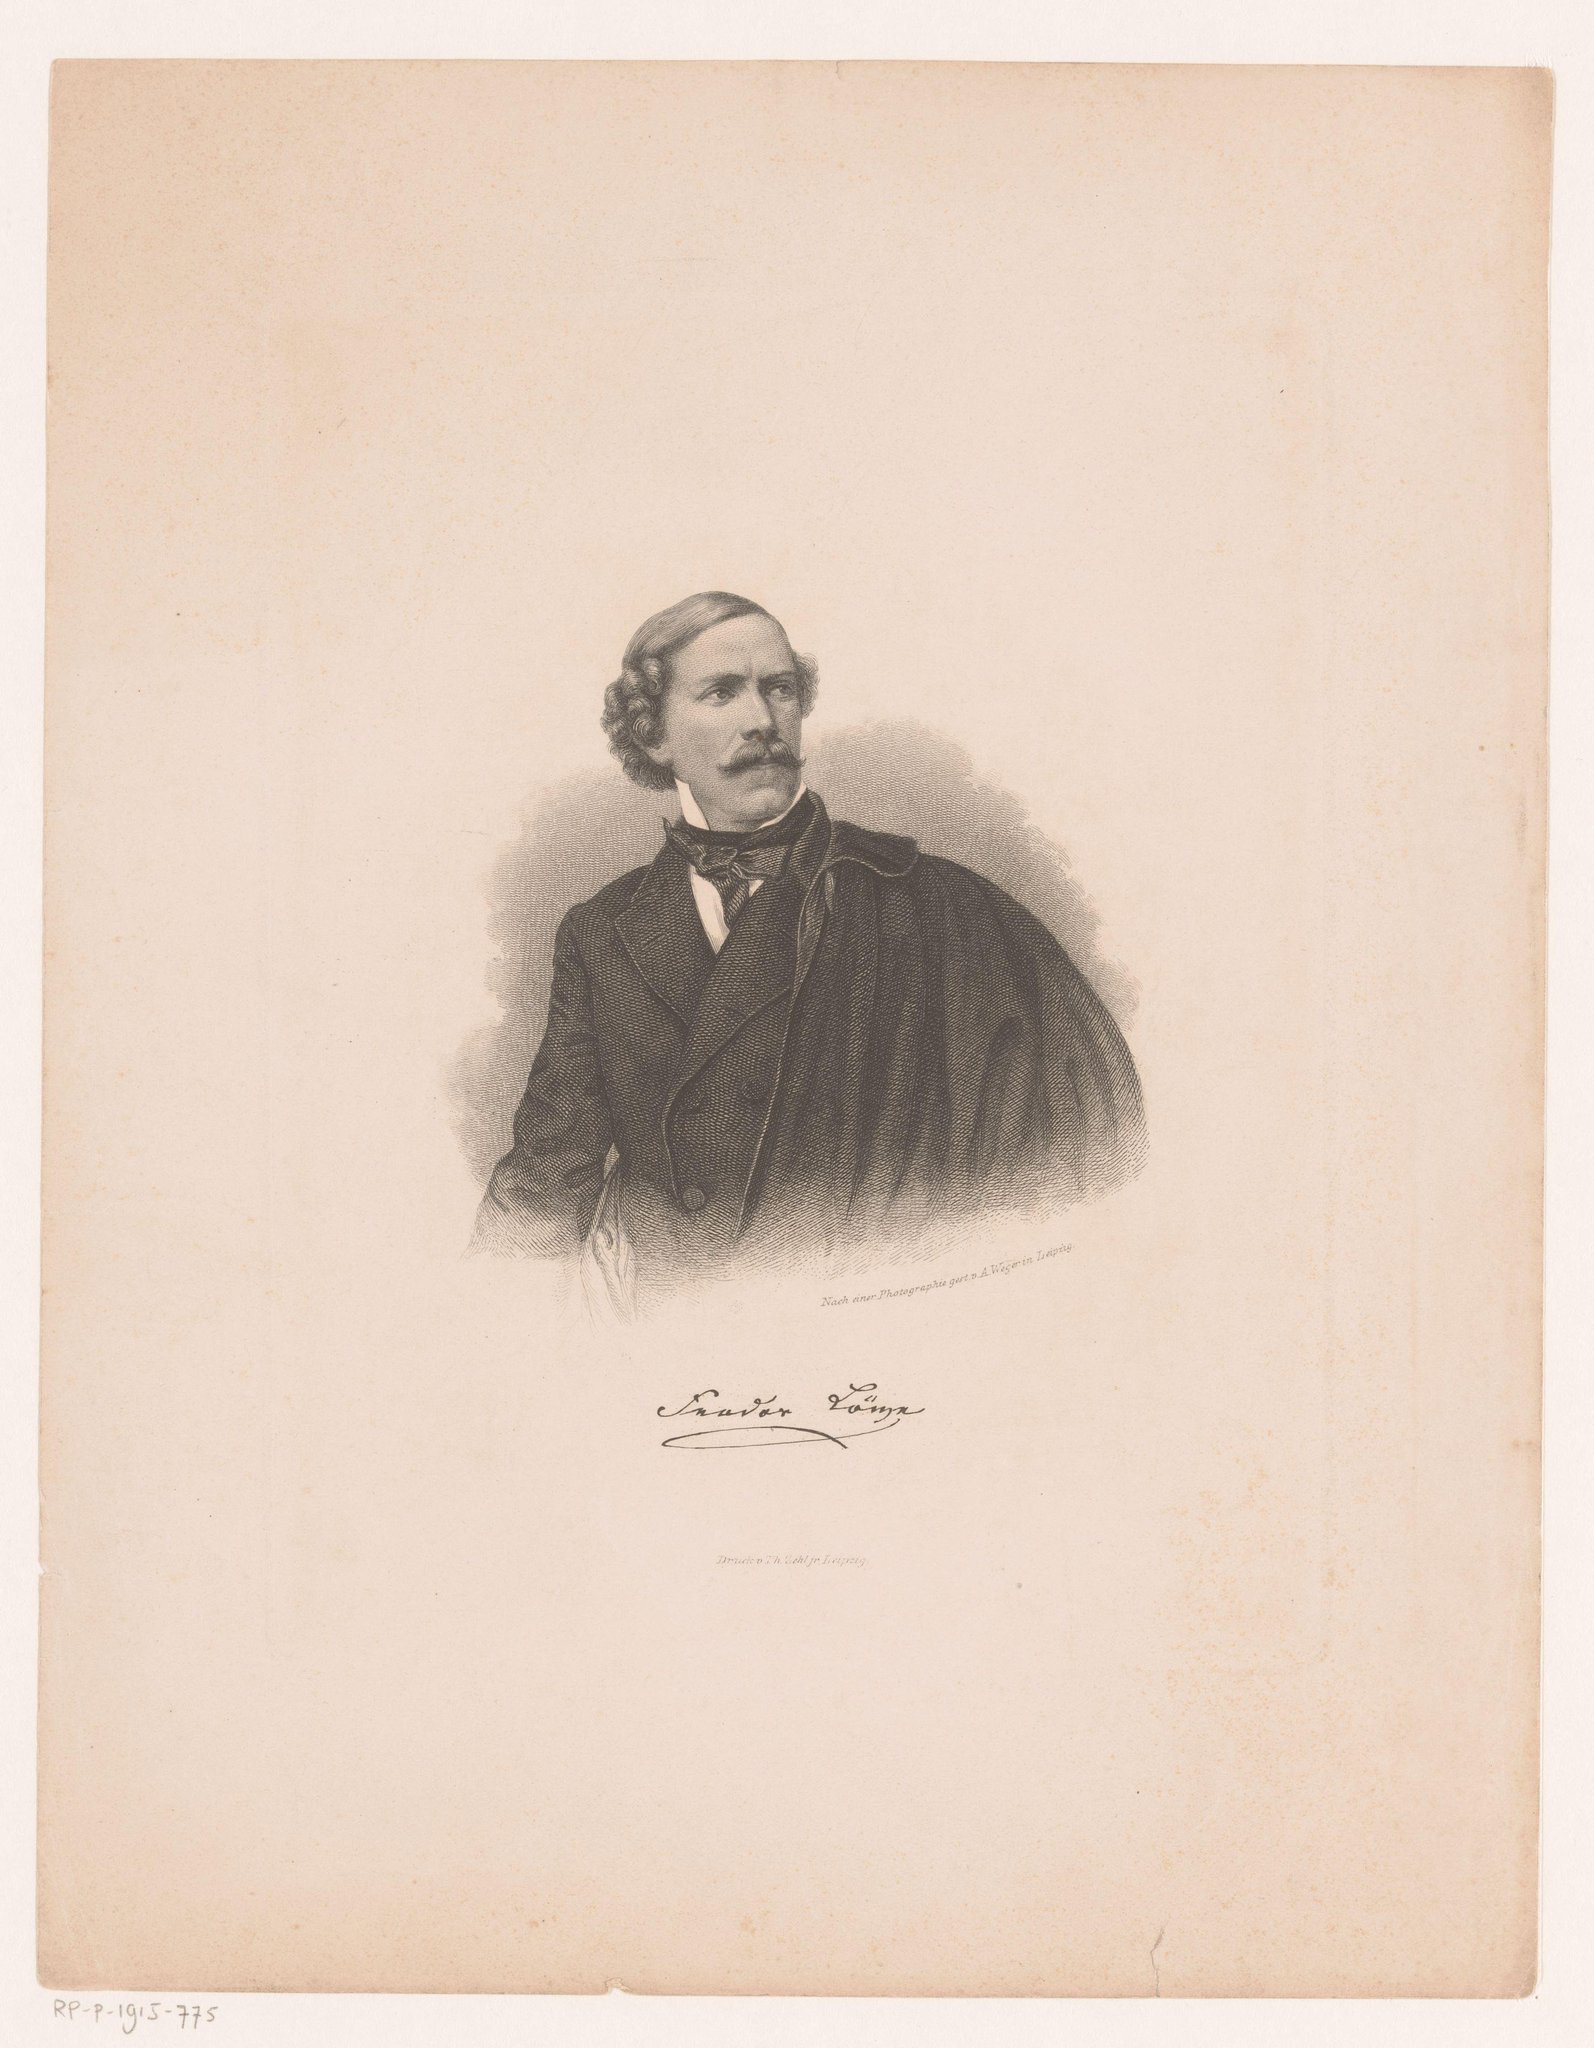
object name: print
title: Portret van de heer Löwe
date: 1849-1892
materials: paper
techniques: engraving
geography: leipzig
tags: historical persons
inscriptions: collector's mark: Lugt 2228